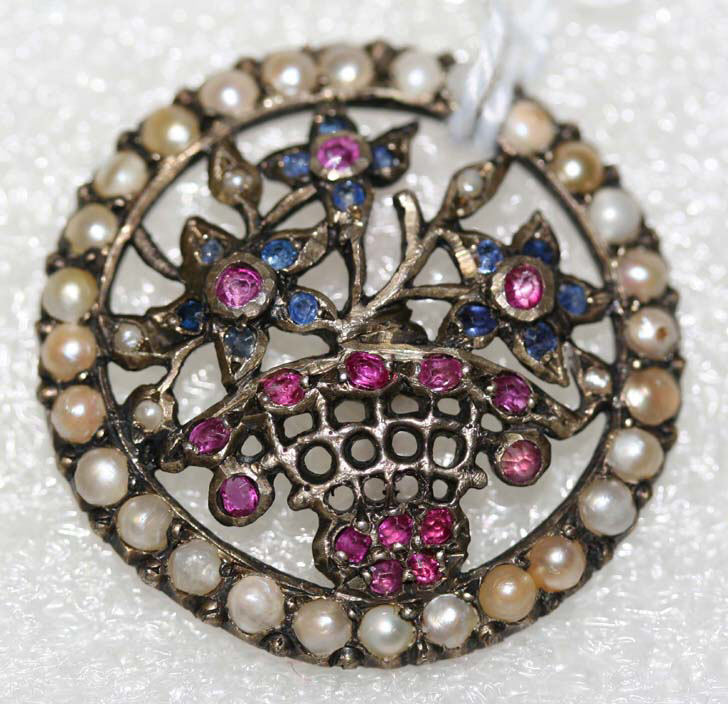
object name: button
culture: french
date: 1775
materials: metal, pearl, gemstone